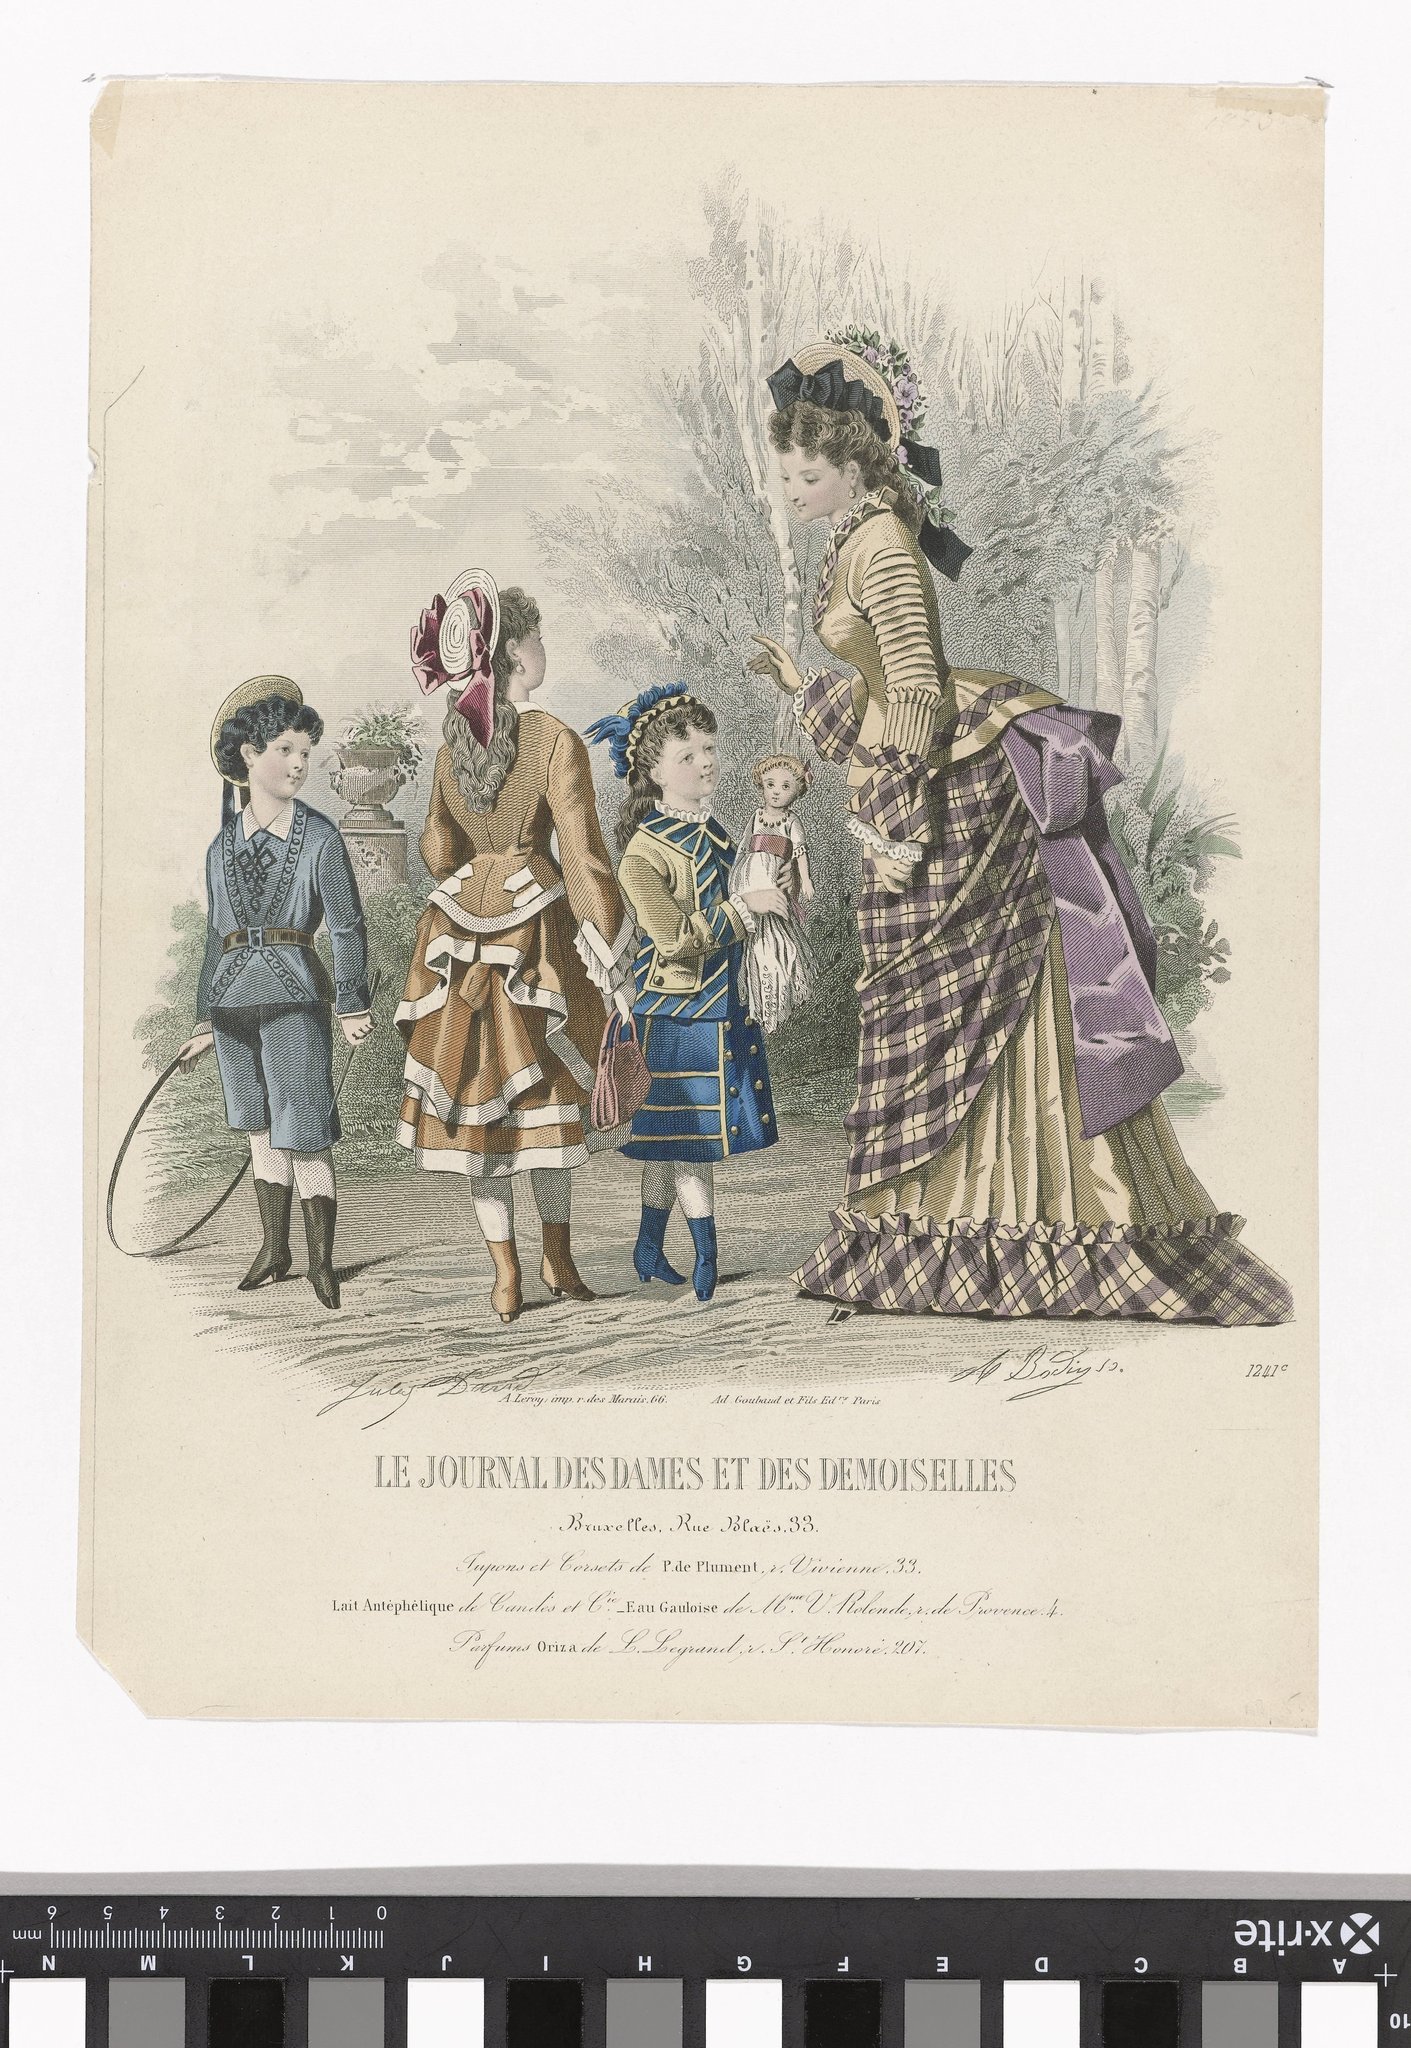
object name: fashion print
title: Le Journal des Dames et des Demoiselles, 1875, No. 1241c : Jupons et Corsets (...)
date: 1875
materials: paper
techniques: engraving, hand coloring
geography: paris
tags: bag (+ girls' clothes), trousers, breeches, etc. (breeches) (+ boys' clothes), boots (+ boys' clothes), head-gear (+ girls' clothes), clothing for the upper part of the body (+ boys' clothes), boots (+ girls' clothes), head-gear (+ boys' clothes), belt, girdle, waistband (+ boys' clothes), ensembles of pieces of clothing (matelot) (+ boys' clothes), head-gear (+ women's clothes), fashion plates, skirt (+ women's clothes), dress, gown (+ women's clothes), (bowling a) hoop, (playing with) dolls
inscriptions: caption: ‘Jupons et Corsets de P. de Plument, r, Vivienne, 33. Lait Antéphélique de Candés et Cie_ Eau Gauloise de Mme V. Rolende.r. de Provence .4 Parfums Oriza de L.Legrand.r. St Honoré.207’, address: ‘Bruxelles, Rue Blaës,33’, title: ‘Le Journal des Dames et des Demoiselles’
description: Vrouw met drie kinderen buiten, zij is gekleed in een japon uit geruite en gele stof met tournure en draagt een hoed. De jongen is gekleed in een matrozenpak. De twee meisjes dragen japonnen met jasjes. De rok van het oudere meisje is aan de achterkant opgetrokken. Het jongere meisje heeft een rok met knopen en strepen op het jasje. Onder de voorstelling enkele regels reclametekst voor verschillende producten. Prent uit het modetijdschrift Journal des Dames et des Demoiselles (1841-1902).